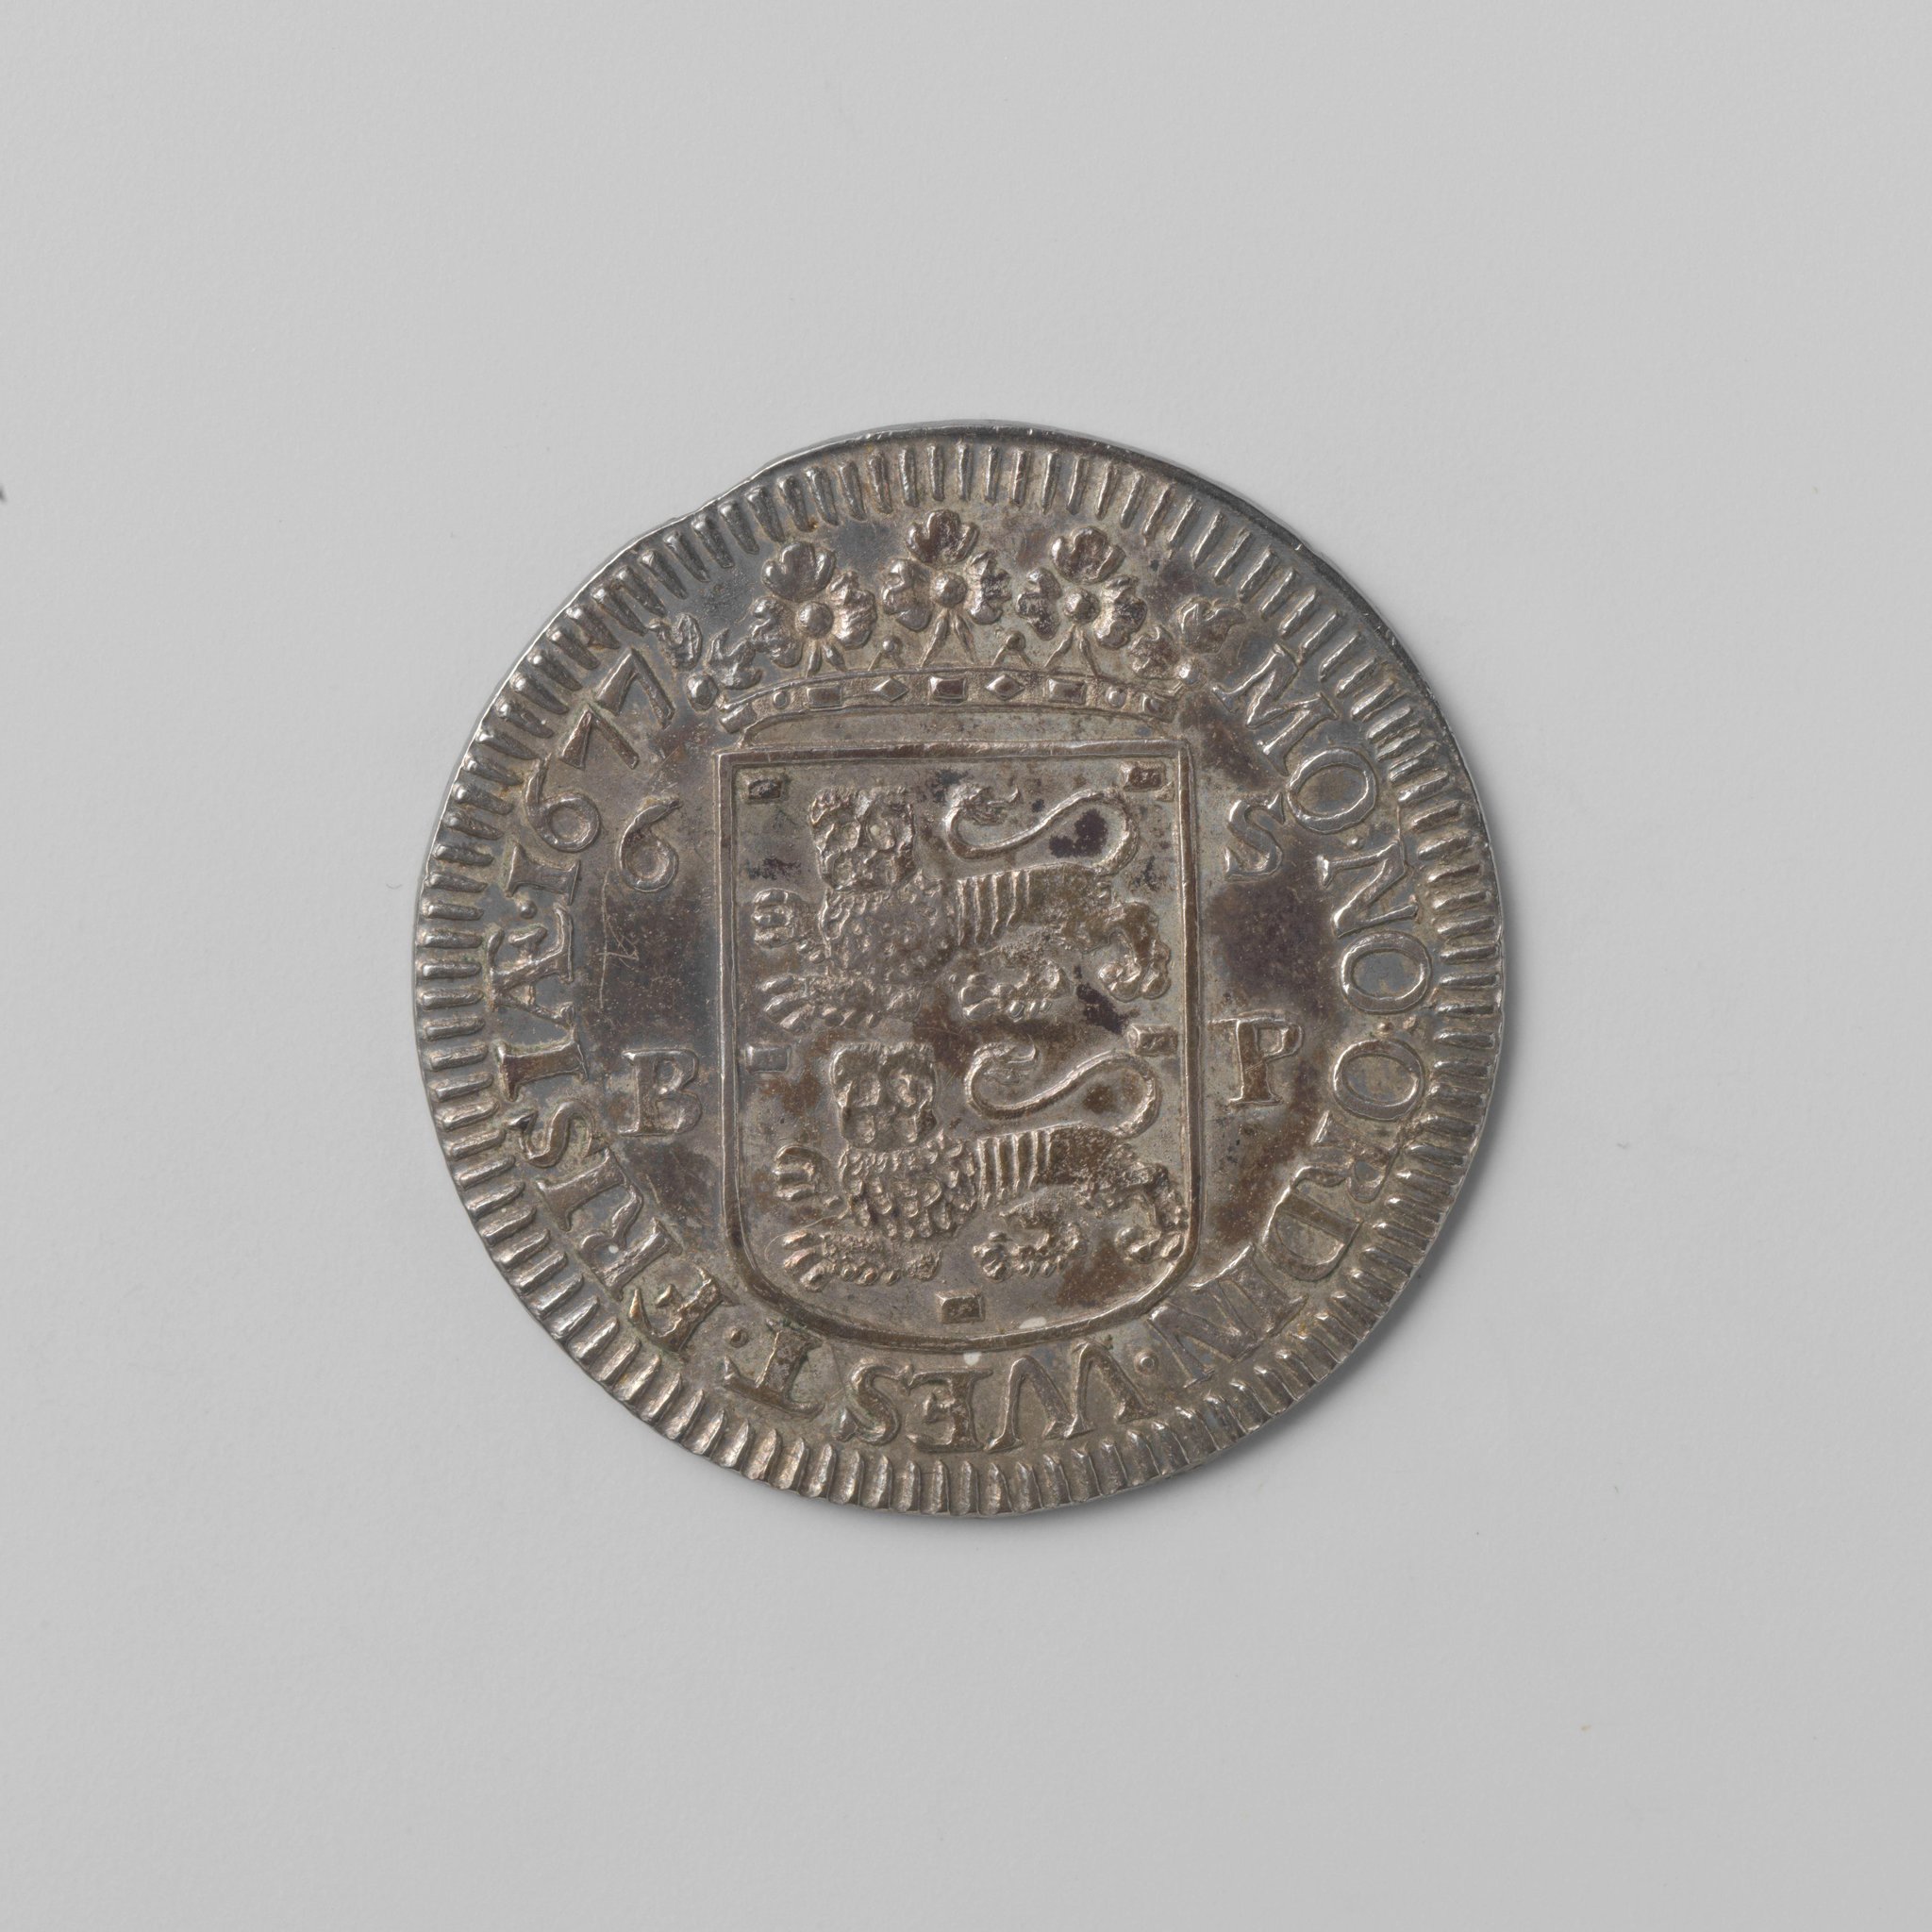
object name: coin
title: West-Friesland, scheepjesschelling, 1676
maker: dirck bosch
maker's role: mintmaster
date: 1676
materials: silver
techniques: striking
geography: enkhuizen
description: Zilveren munt. Voorzijde: tussen waarde-aanduiding 6 en S en daaronder de letters B en P gekroond wapenschild van West-Friesland. Keerzijde: schip met zeilen naar rechts.